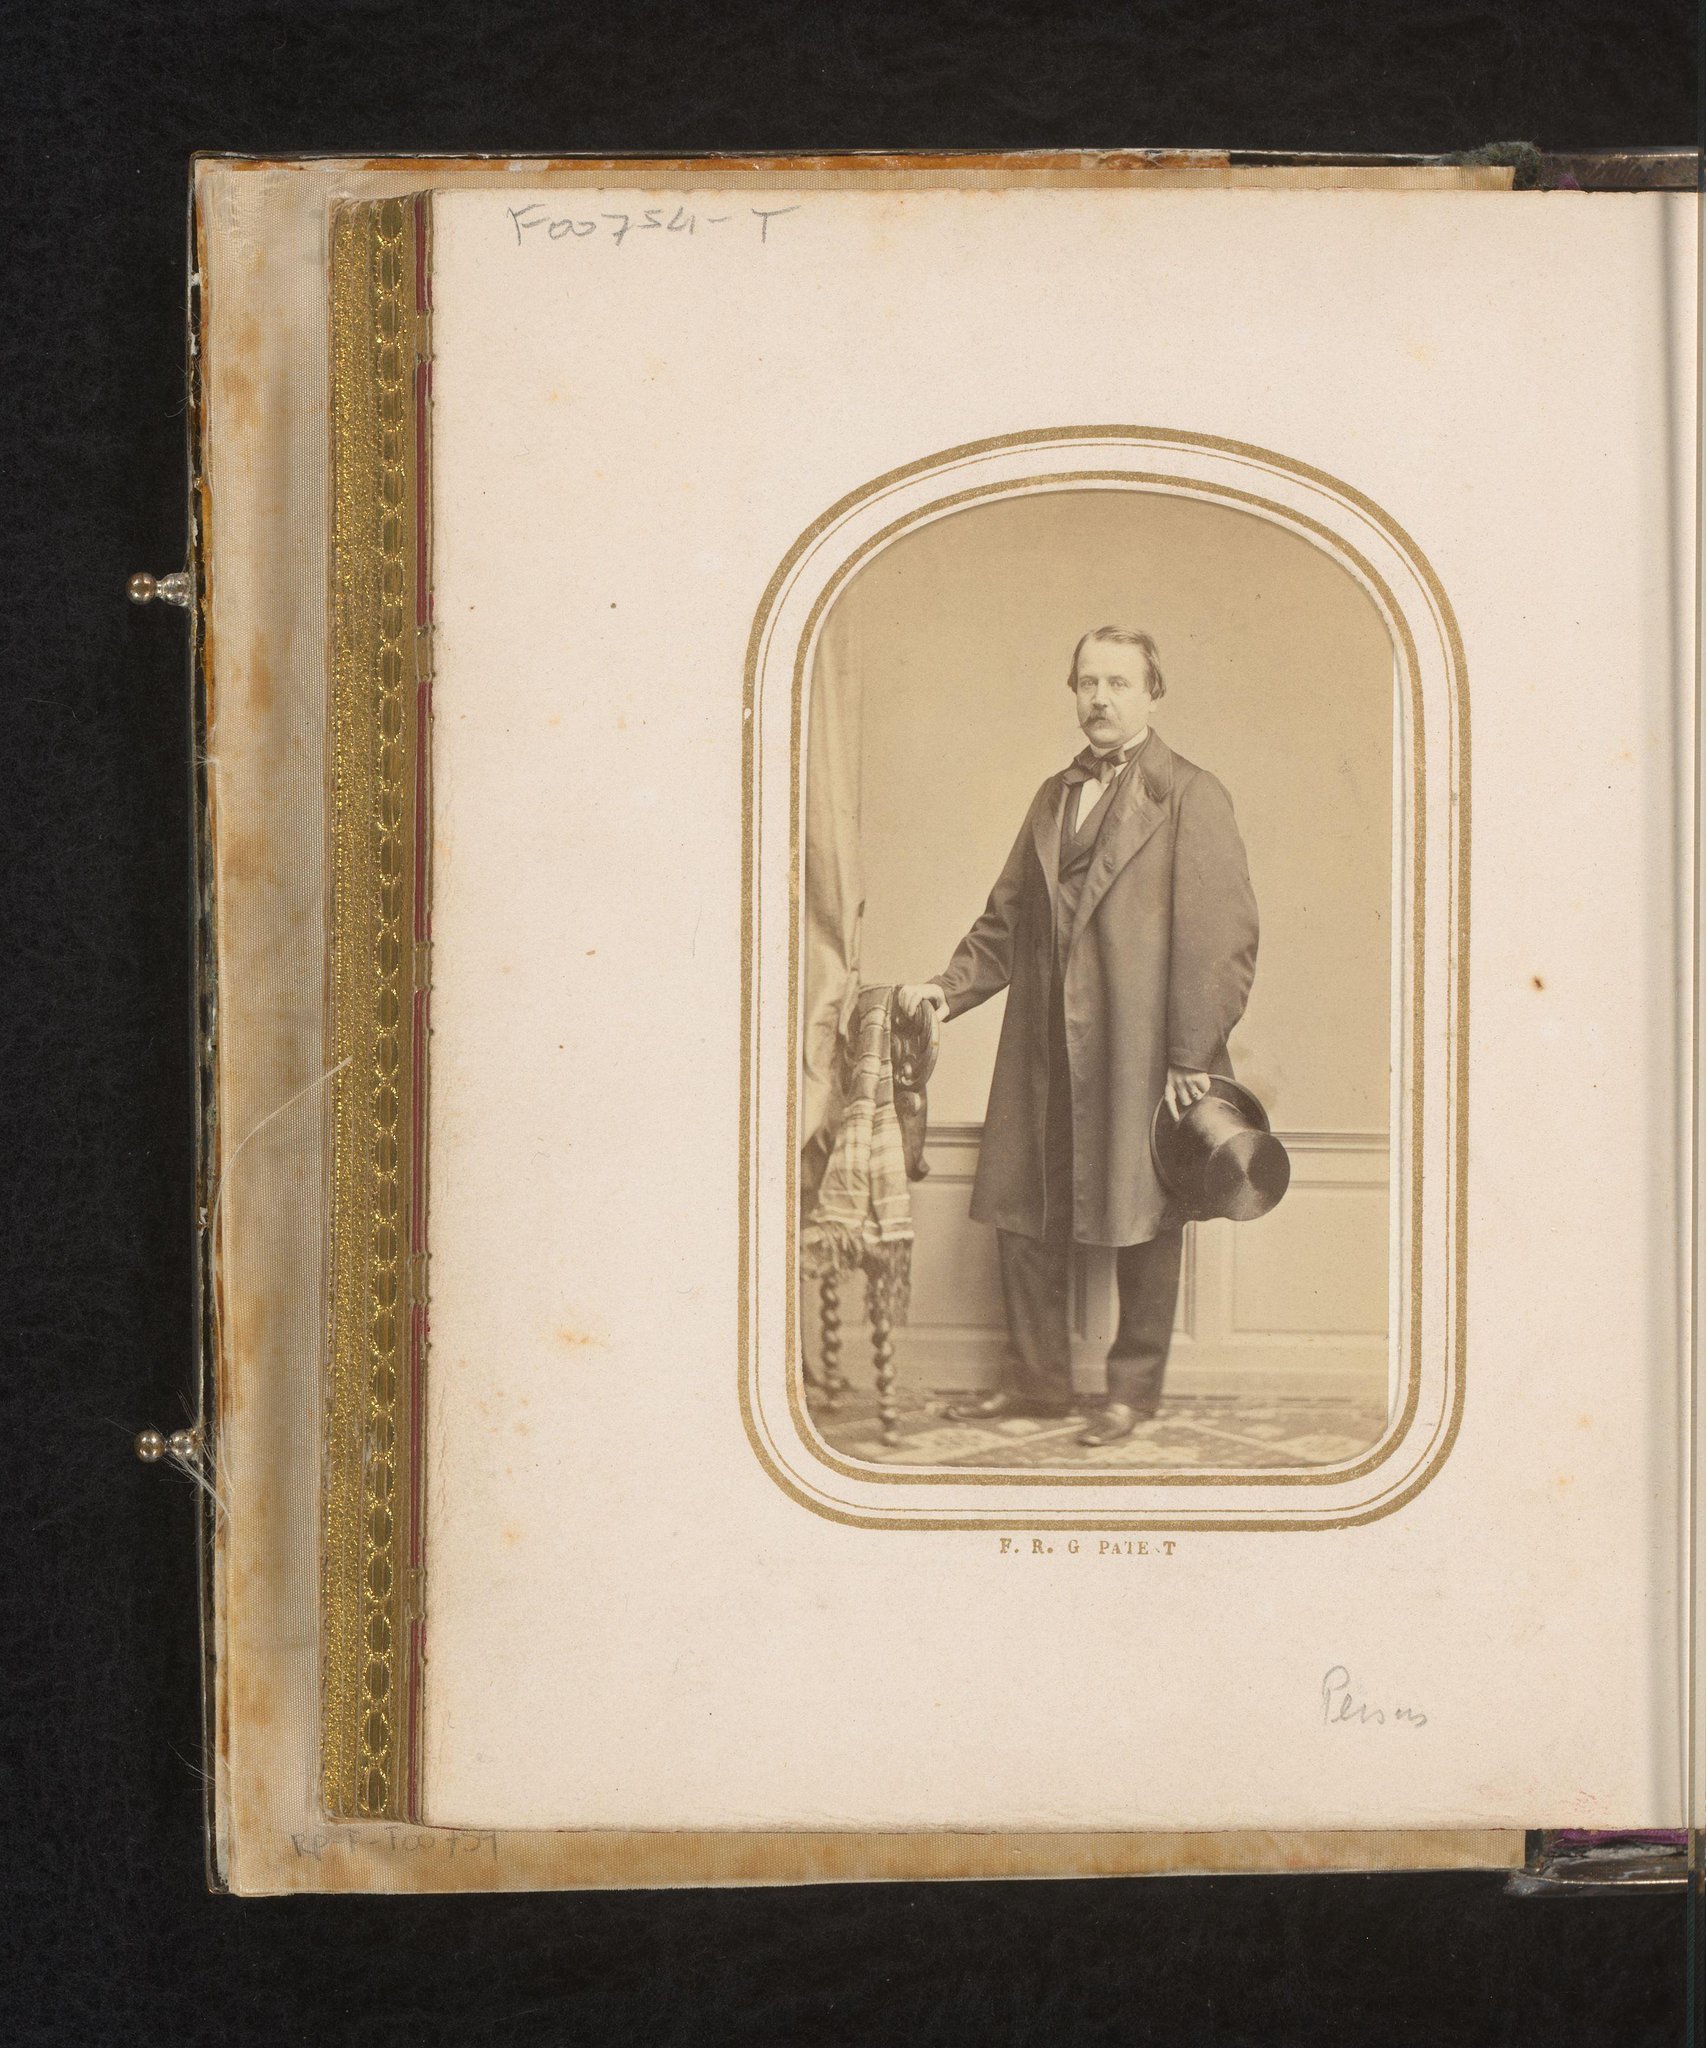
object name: album leaf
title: Portret van Felix Parmentier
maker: nicolas claude persus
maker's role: fotograaf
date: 1855-1880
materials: cardboard, photographic support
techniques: albumen print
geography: paris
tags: historical persons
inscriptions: name: ‘Felix Parmentier’, inscription: ‘Persus/ Photographe/ 8, Rue Cassette/ au Rez-de-Chaussée/ Paris’